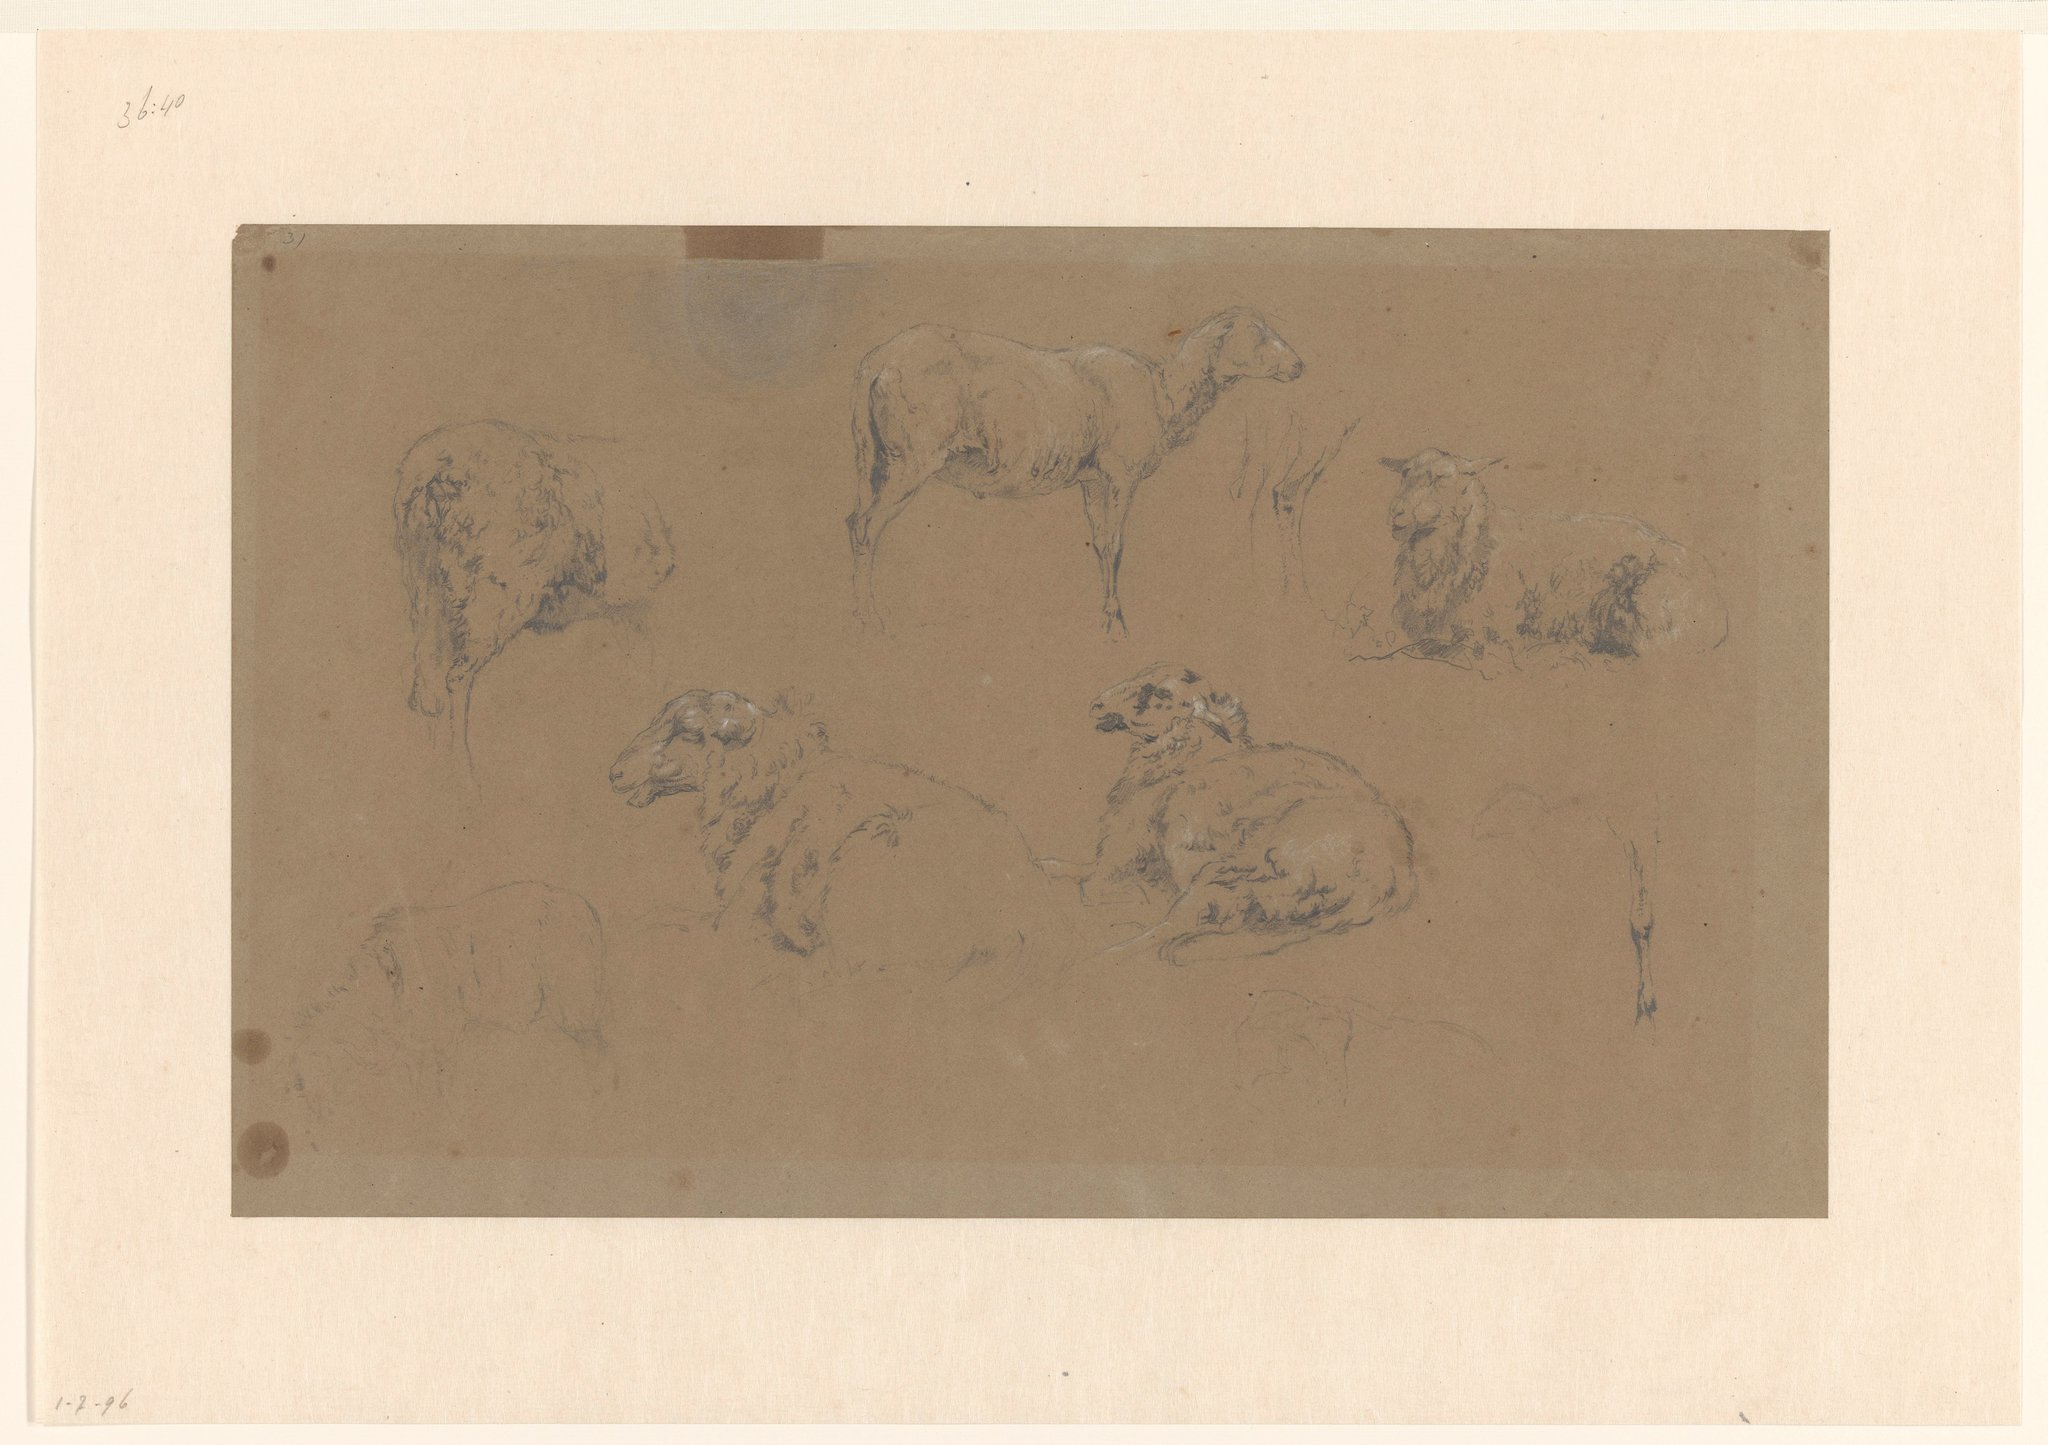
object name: drawing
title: Schetsblad met studies van schapen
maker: gerard bilders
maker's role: draughtsman, print maker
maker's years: 1838-1865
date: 1848-1865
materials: chalk, paper, pencil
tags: sheep